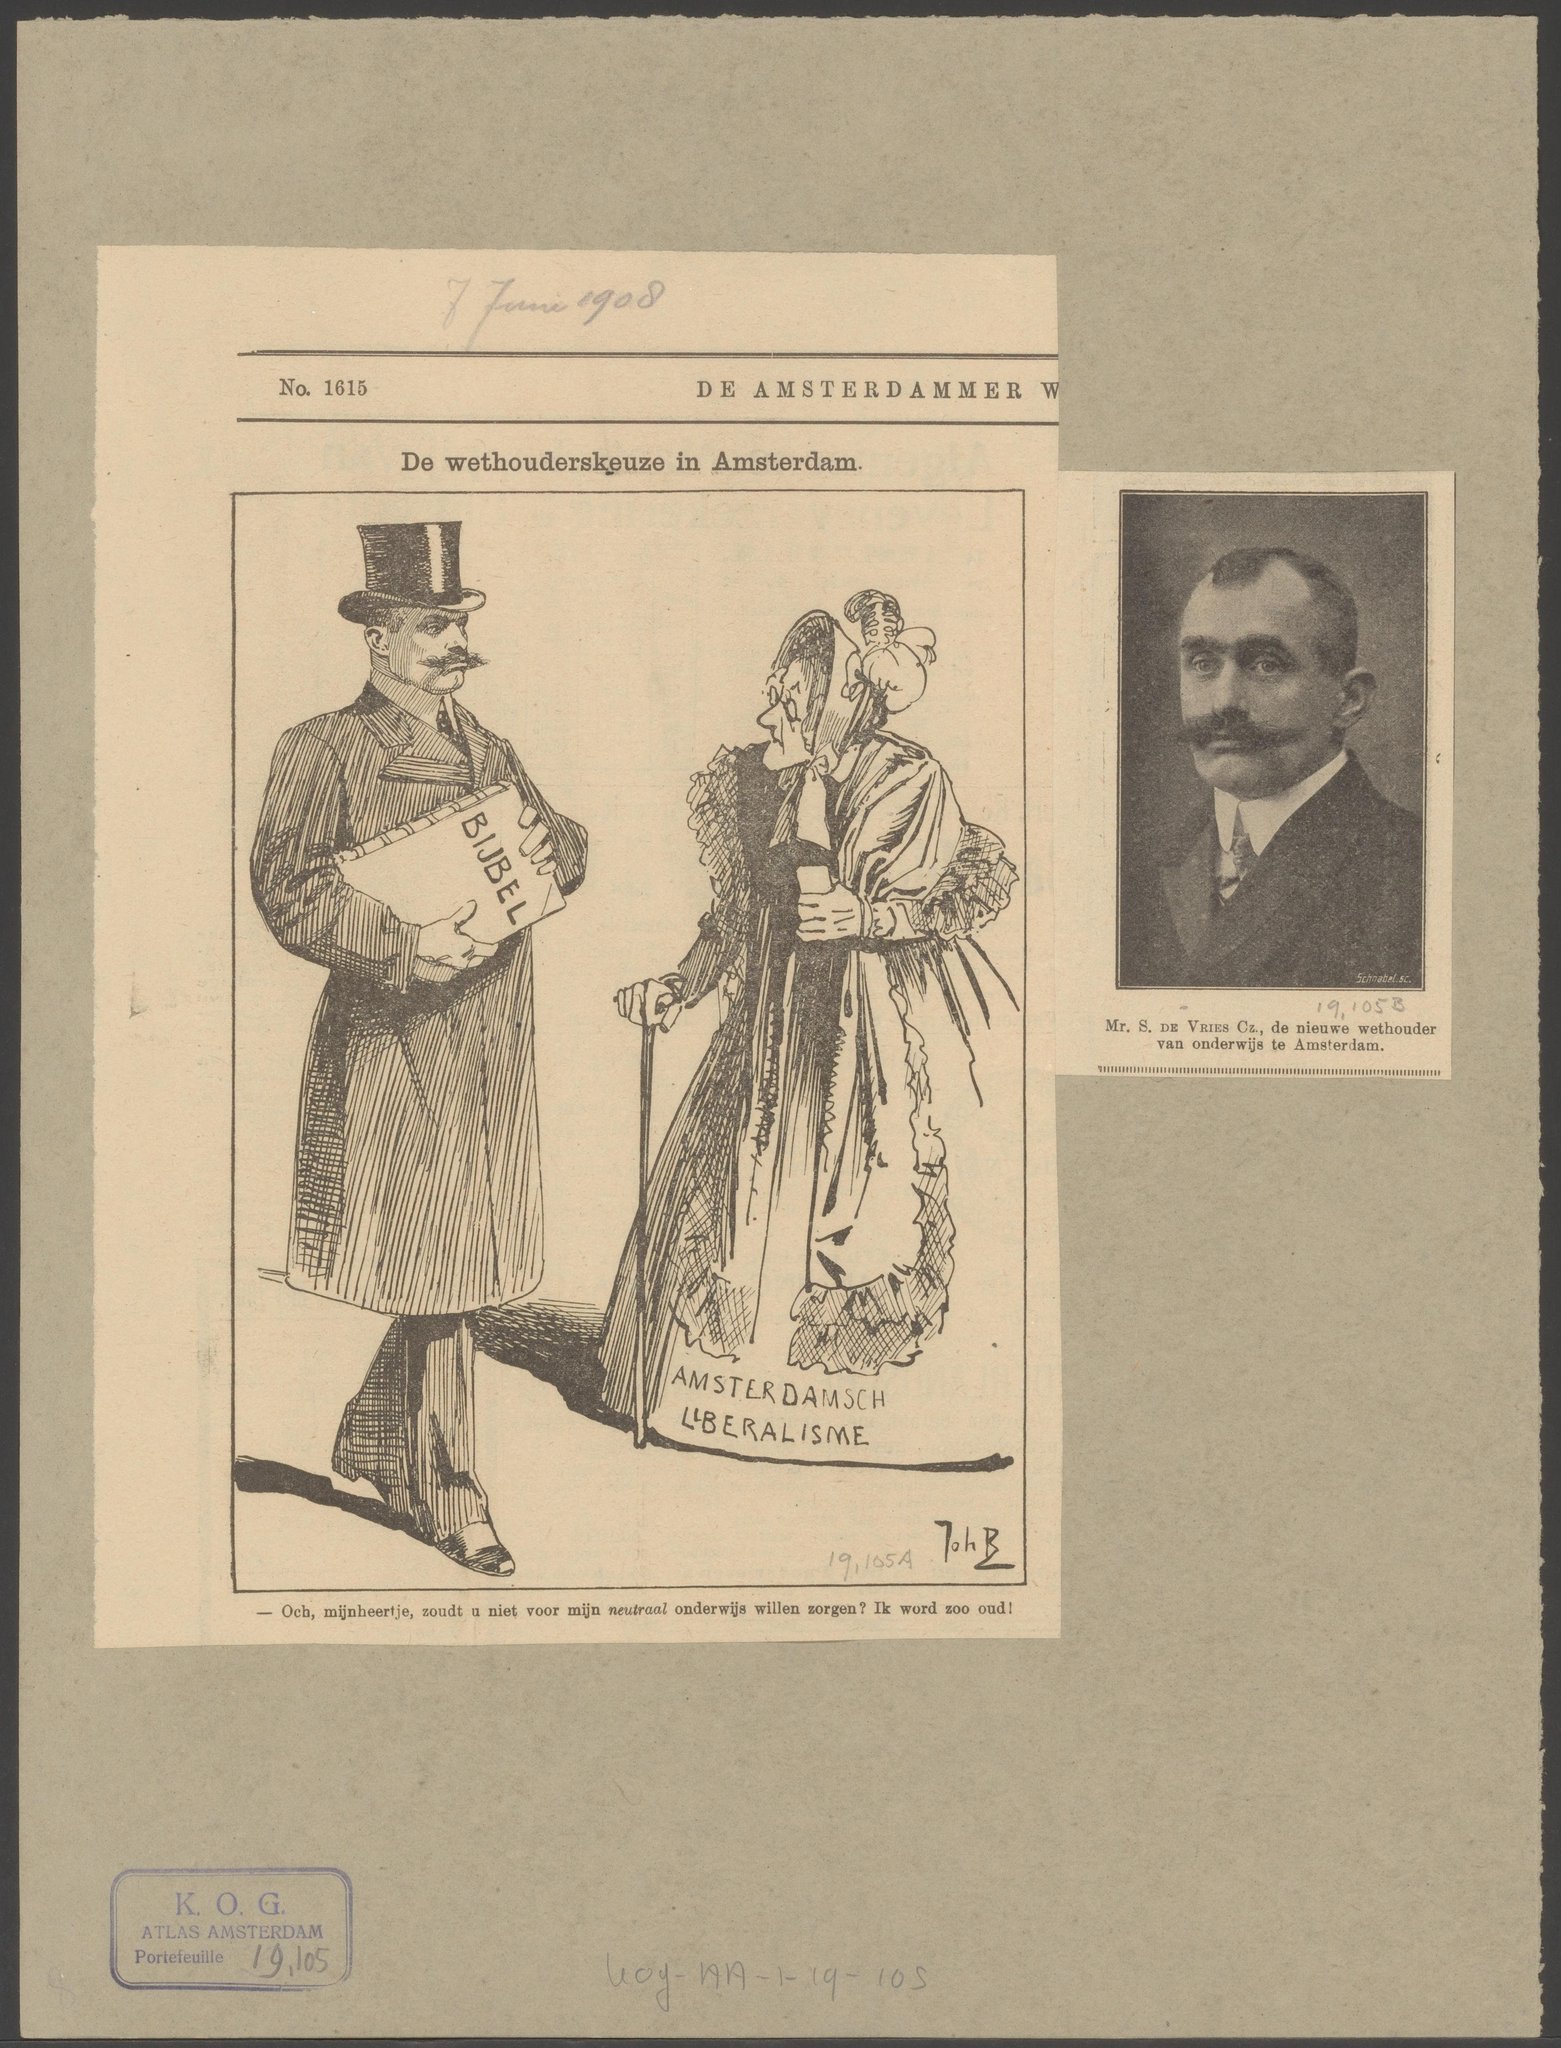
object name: photomechanical print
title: Portret van S. de Vries Czn.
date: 1908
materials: paper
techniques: letterpress printing, line block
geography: amsterdam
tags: politician, historical persons, politician, e.g. party leader, political caricatures and satires, amsterdam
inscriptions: collector's mark: ‘19,105’ Lugt 1641b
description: Onderwerpsrubriek binnen de Atlas Amsterdam: Herinneringen aan regeringsleden en hunne huisgezinnen [na 1800].